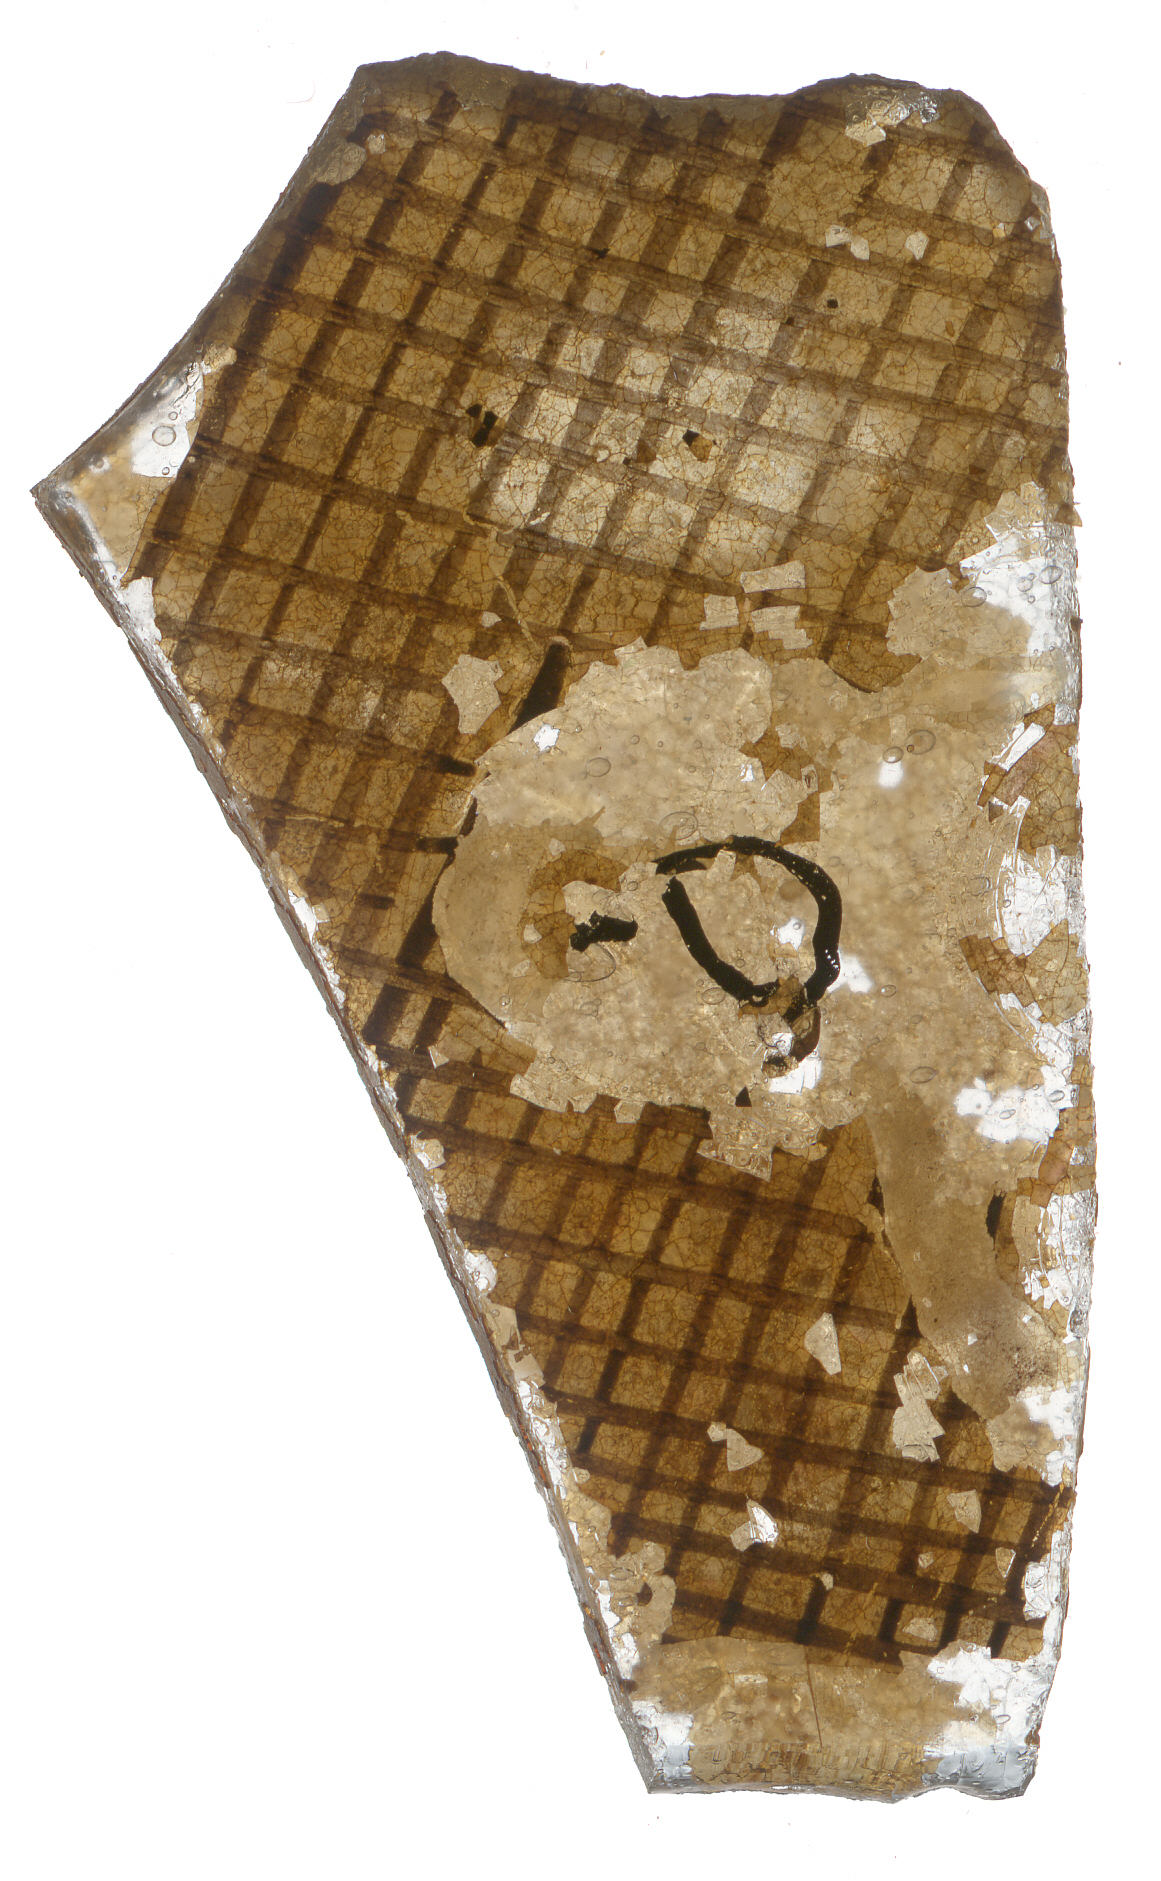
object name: fragment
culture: crusader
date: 1201-1300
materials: glass